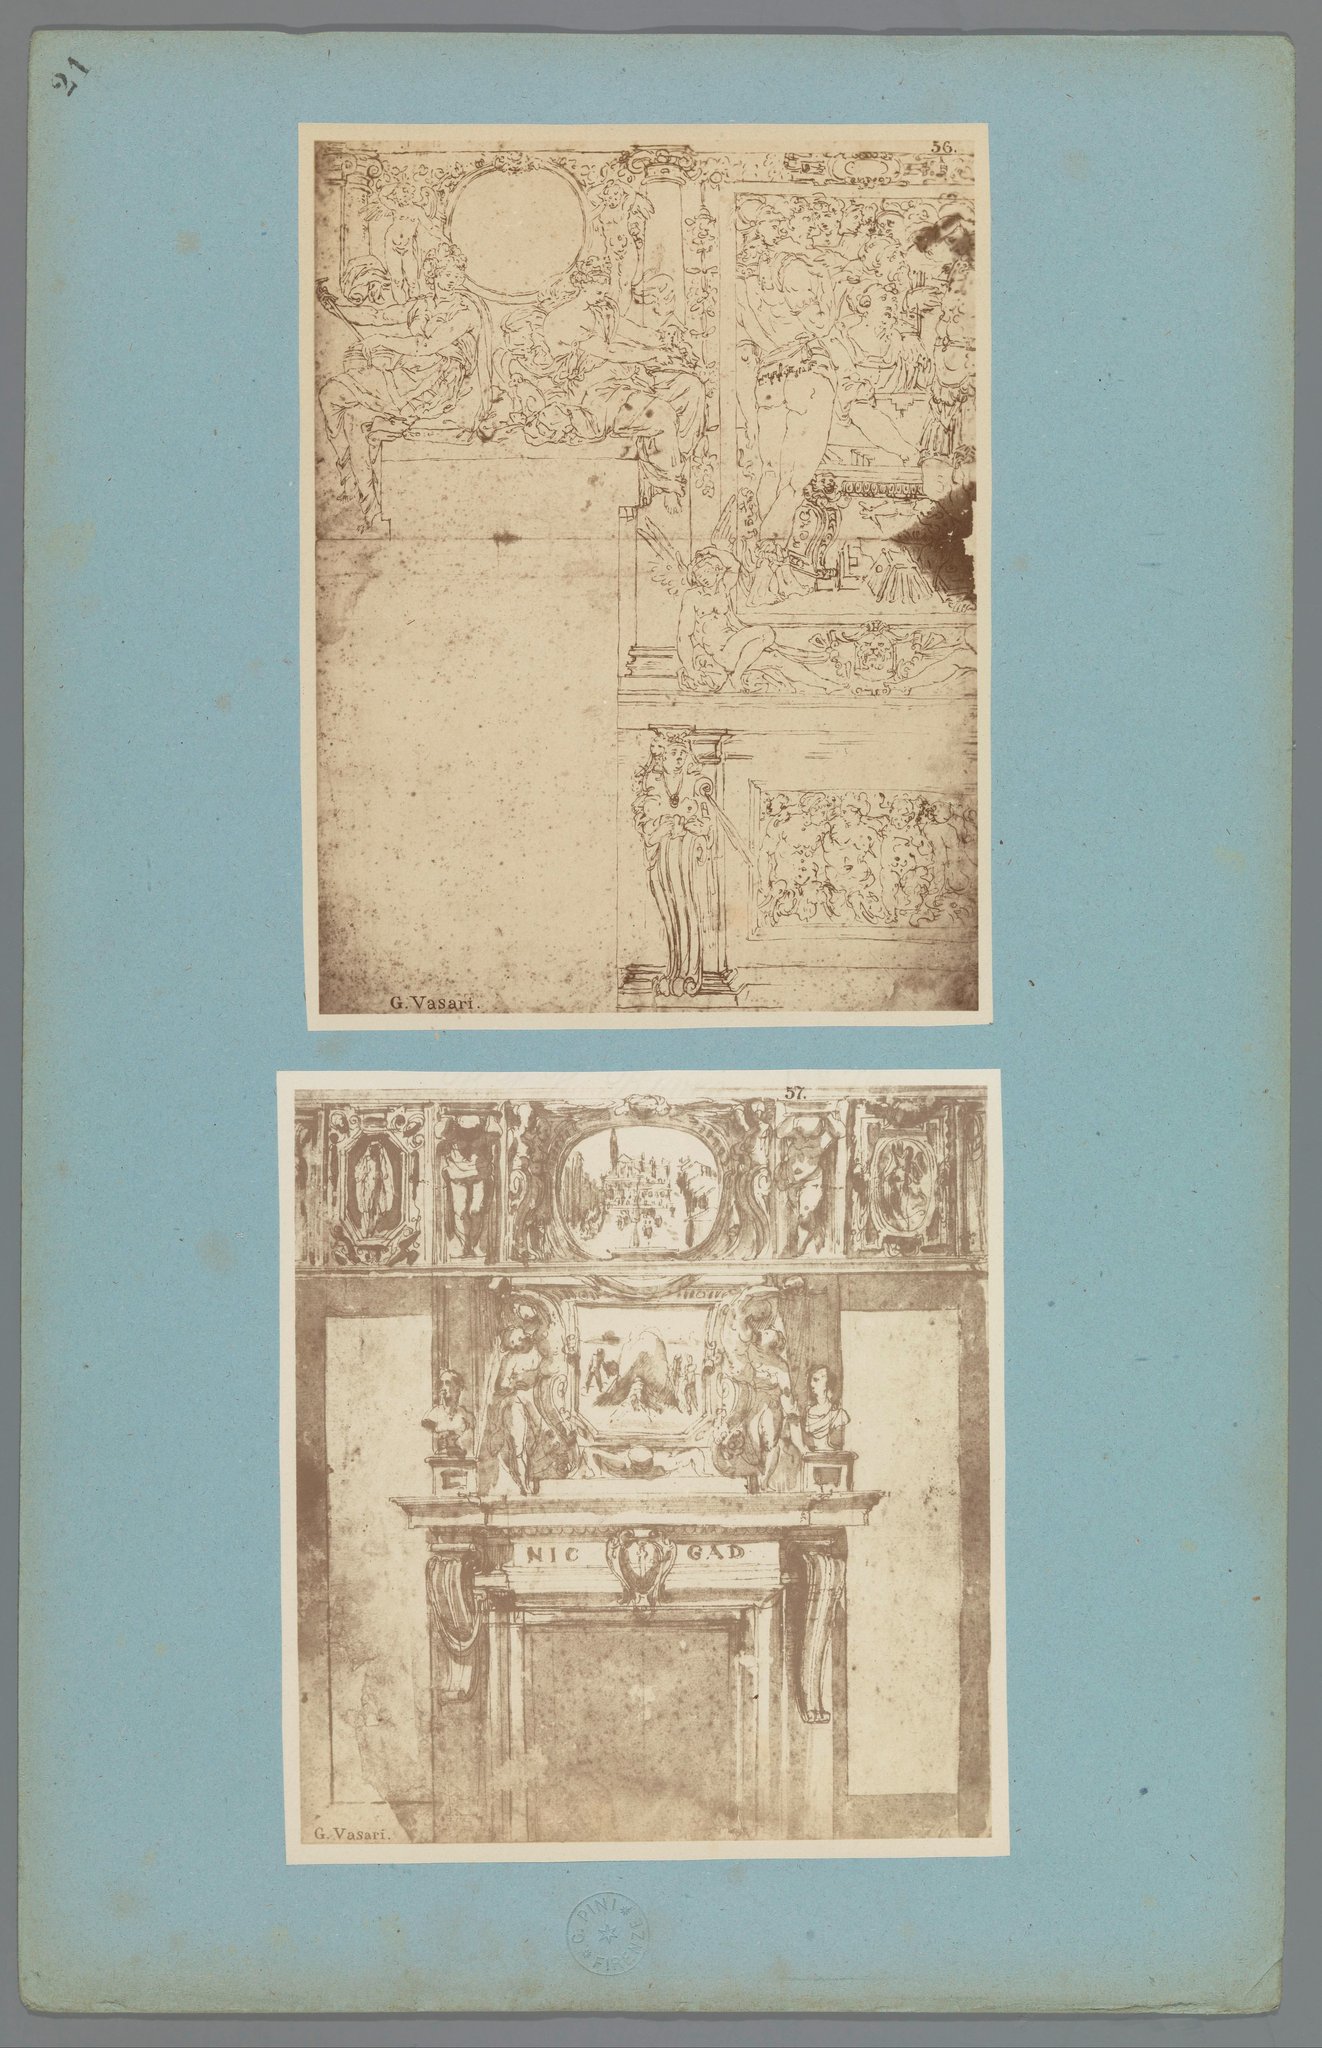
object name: reproduction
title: Twee fotoreproducties van tekeningen van wanddecoratie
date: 1875-1900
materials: cardboard, photographic support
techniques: albumen print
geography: europe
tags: atlantes ~ architecture, open hearth, fire-place, picture, painting, leaning figure, europe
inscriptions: number: ‘57.’, number: ‘21’, number: ‘56.’, name: ‘C. PINI FIRENZE’, collector's mark: Lugt 3937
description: Boven (56) een tekening van wanddecoratie met figuren en (vermoedelijk) een schouw, onder (57) een tekening van een interieur met een schouw.